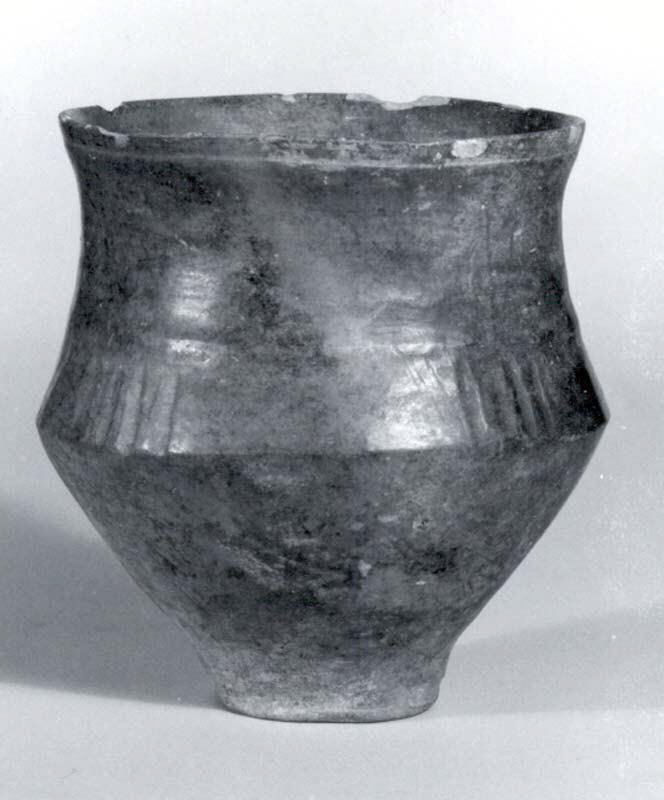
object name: vessel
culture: iranian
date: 900-801 BCE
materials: ceramic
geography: iran